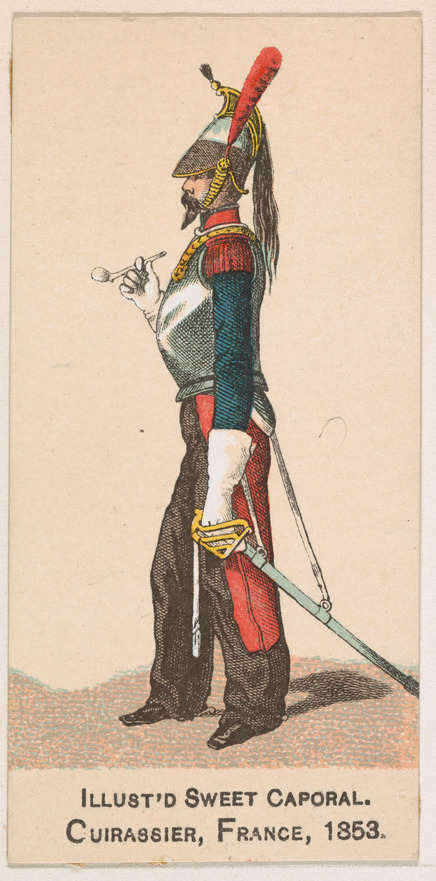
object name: print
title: Cuirassier, France, 1853, from the Military Series (N224) issued by Kinney Tobacco Company to promote Sweet Caporal Cigarettes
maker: kinney brothers tobacco company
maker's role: publisher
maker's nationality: american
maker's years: 1869-2011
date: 1888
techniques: color lithograph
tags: soldiers,swords,men,profiles